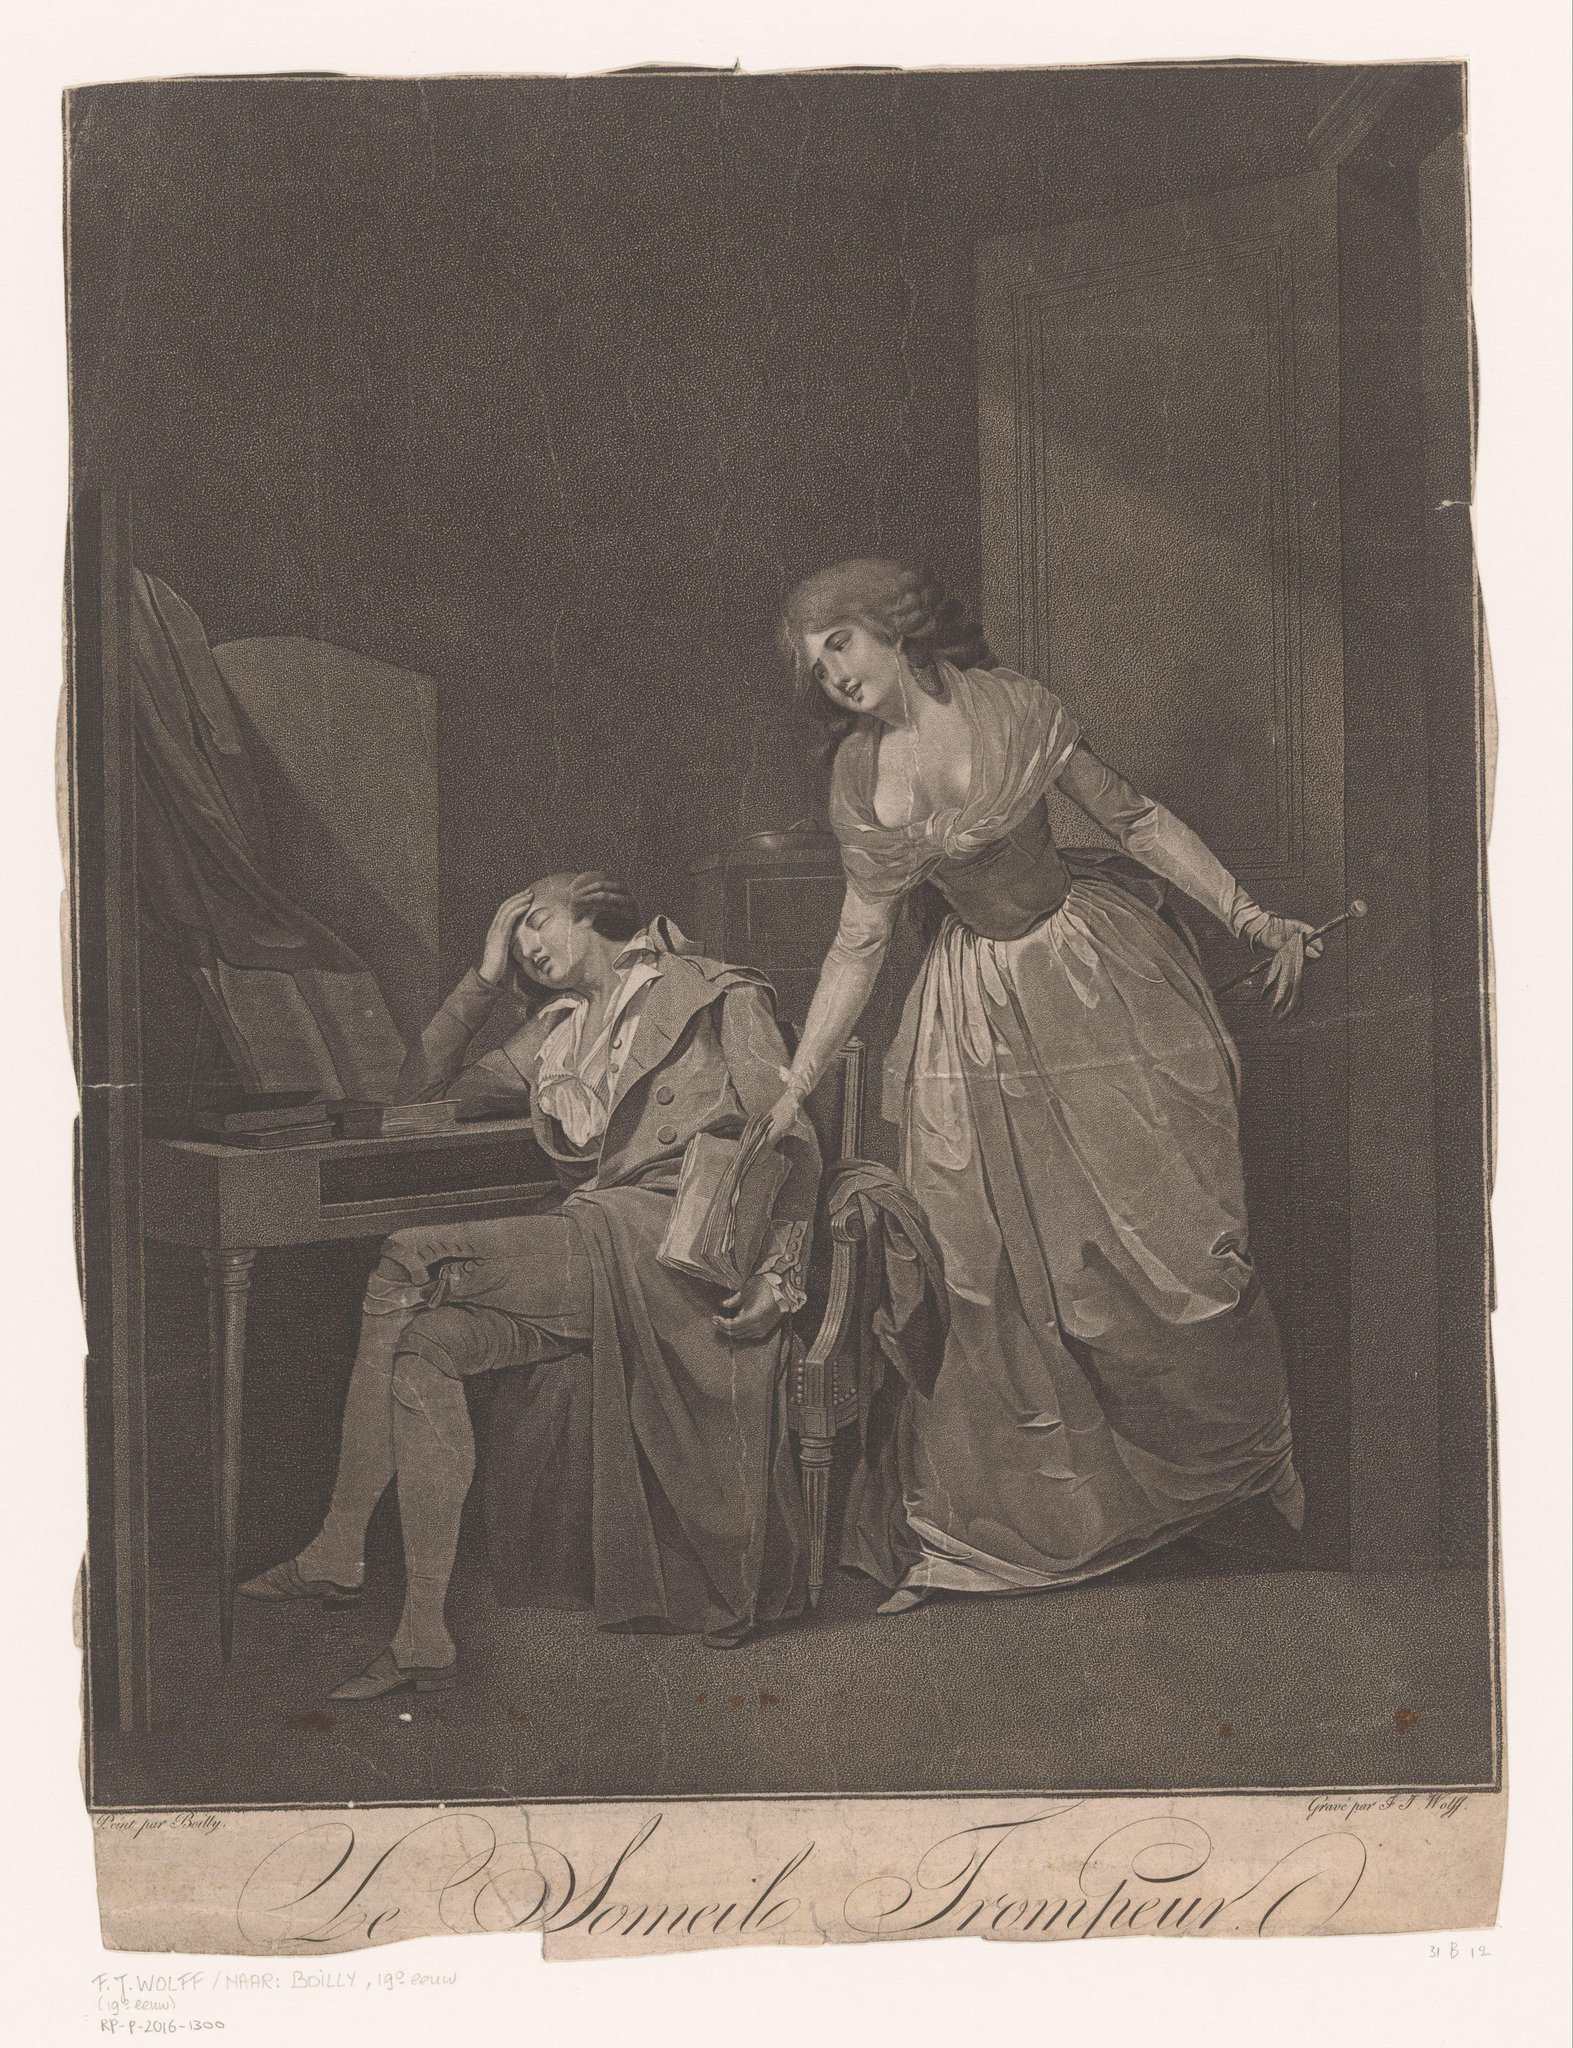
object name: print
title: Le Someil Trompeur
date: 1789-1830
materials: paper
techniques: etching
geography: rotterdam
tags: interior of the house, keyboard instruments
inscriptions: collector's mark: Lugt 2228